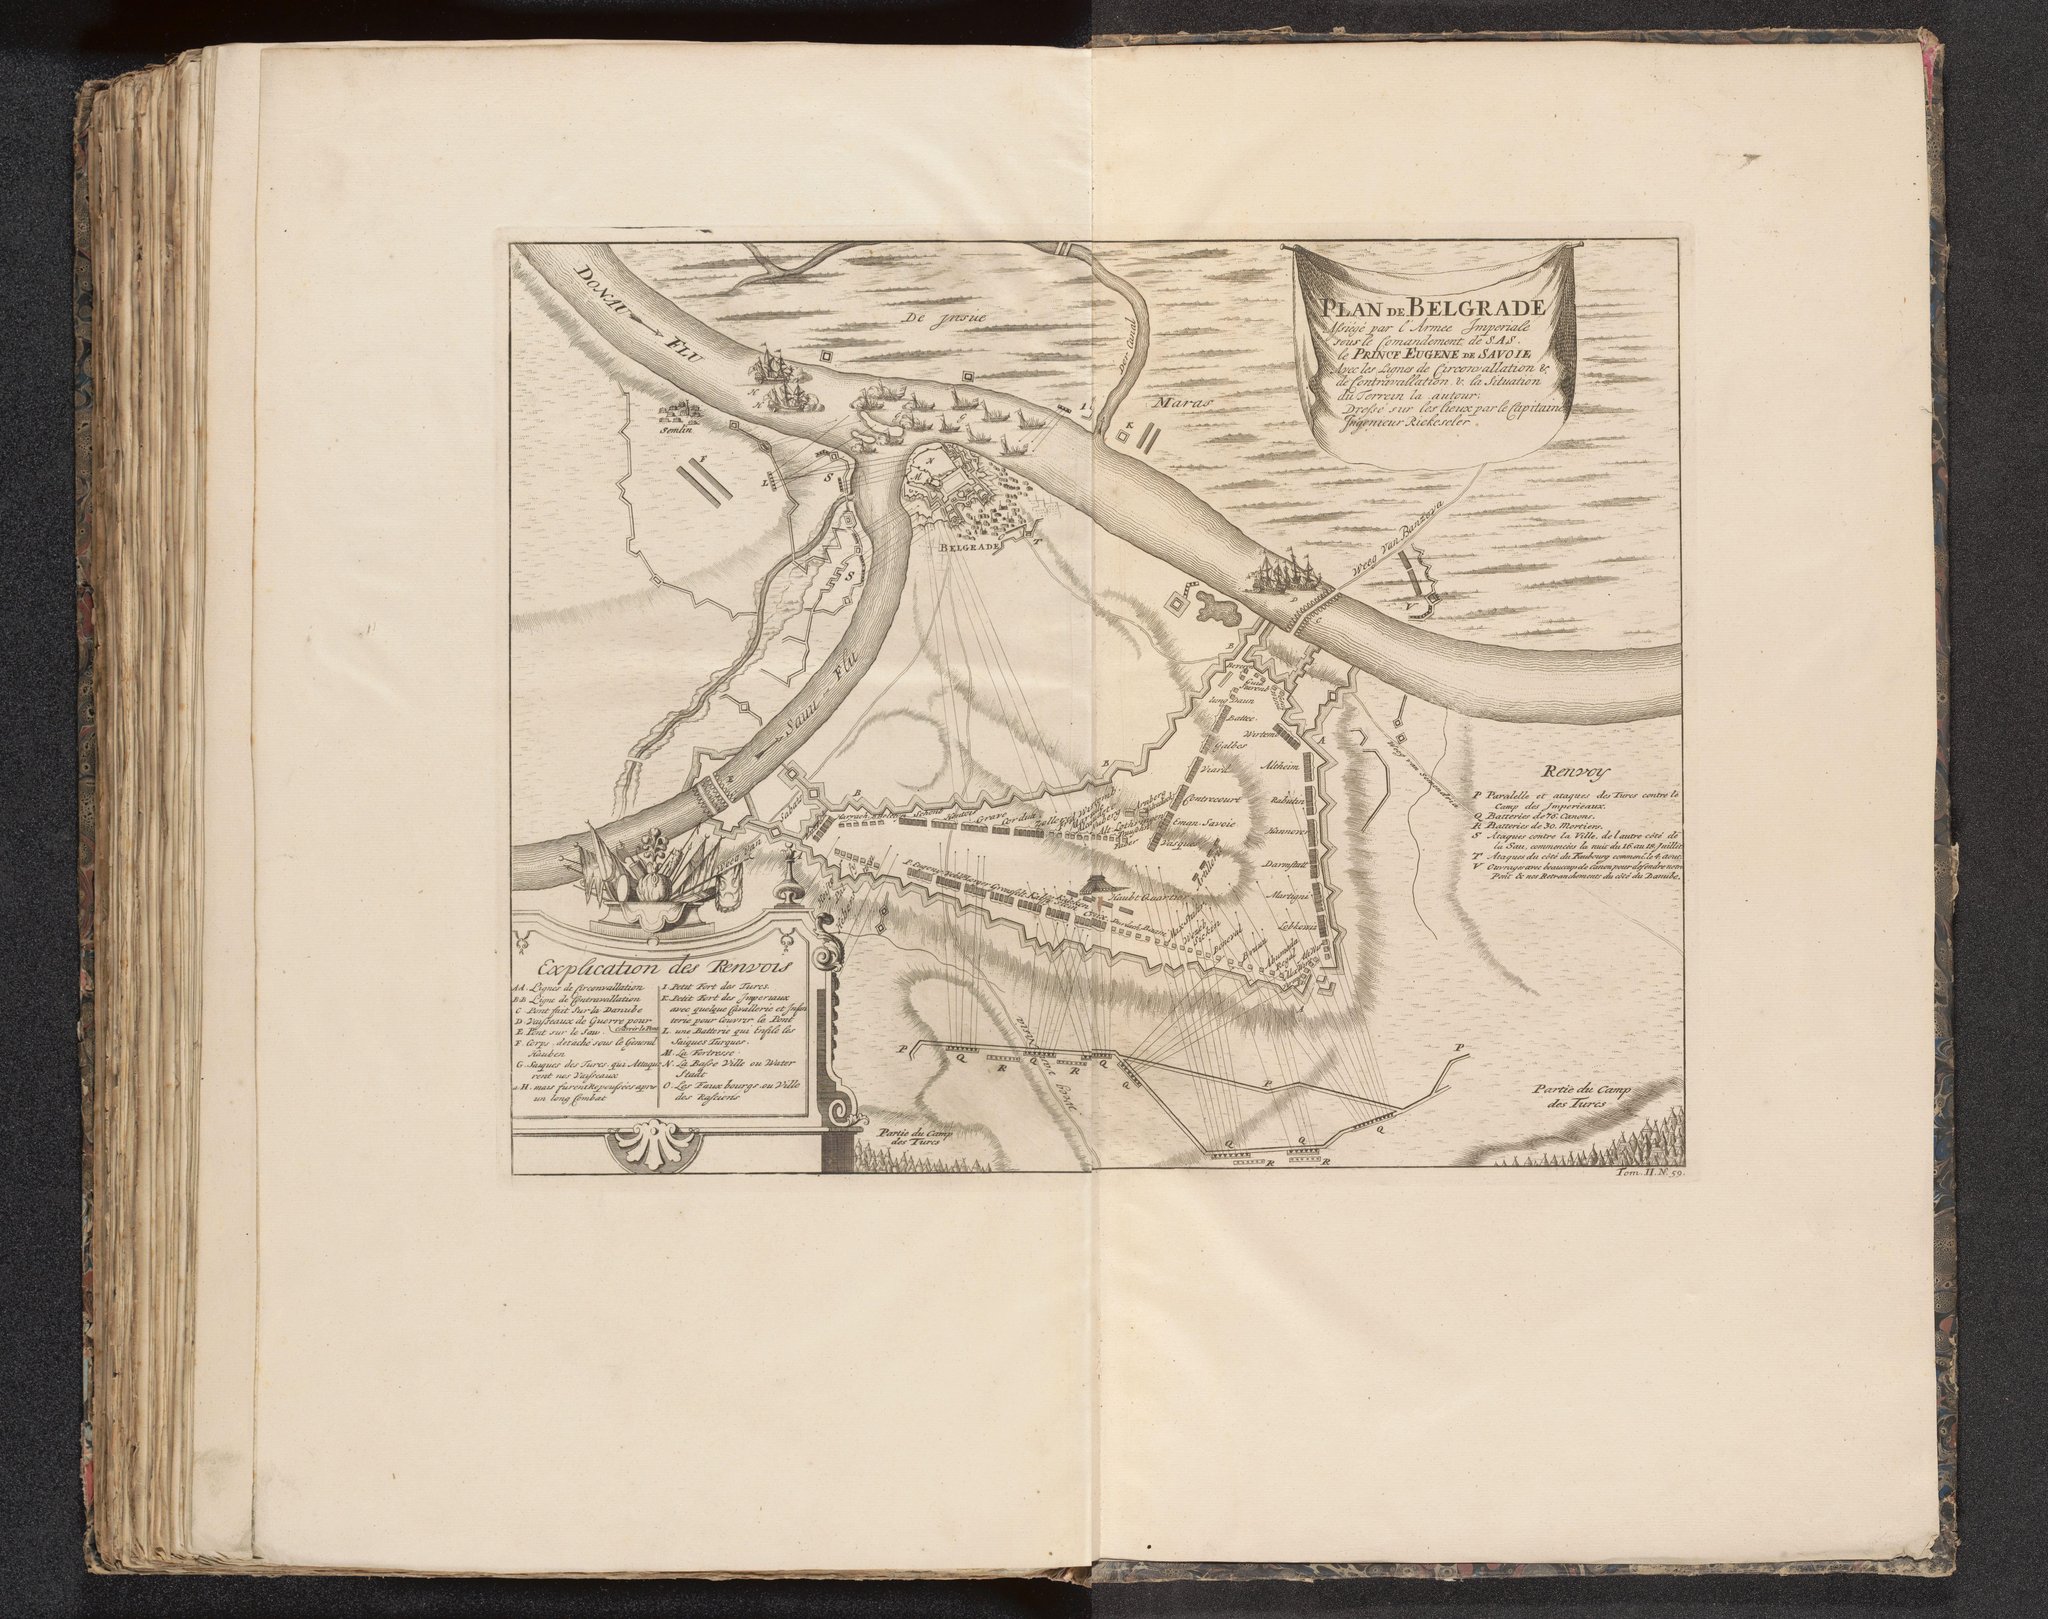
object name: print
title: Plan de Belgrade Assiegé par l'Armée Imperiale sous le Comandement de S.A.S. le Prince Eugene de Savoie (...)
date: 1717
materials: paper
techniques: engraving, etching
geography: northern netherlands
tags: paris, vienna, eugenius van savoye, maps of separate countries or regions, battle (+ land forces)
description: Kaart van de slag bij Belgrado. Verovering van Belgrado op de Turken door de keizerlijke troepen onder Eugenius van Savoye, 16 augustus 1717. Genummerd rechtsonder: Tom. II. No. 69. Illustratie in het tweede deel van : [Jean] du Mont, Oorlogskundige beschryving van de veldslagen en belegeringen, der drie ... wydvermaarde krygsoversten... den Prins Eugenius van Savoye, den ... Hertog van Marlborough, en den Prins van Oranje en Nassau-Vriesland, in de editie van 1729. Dit tweede deel is hoofdzakelijk gewijd aan de daden van de hertog van Marlborough en prins Johan Willem Friso.